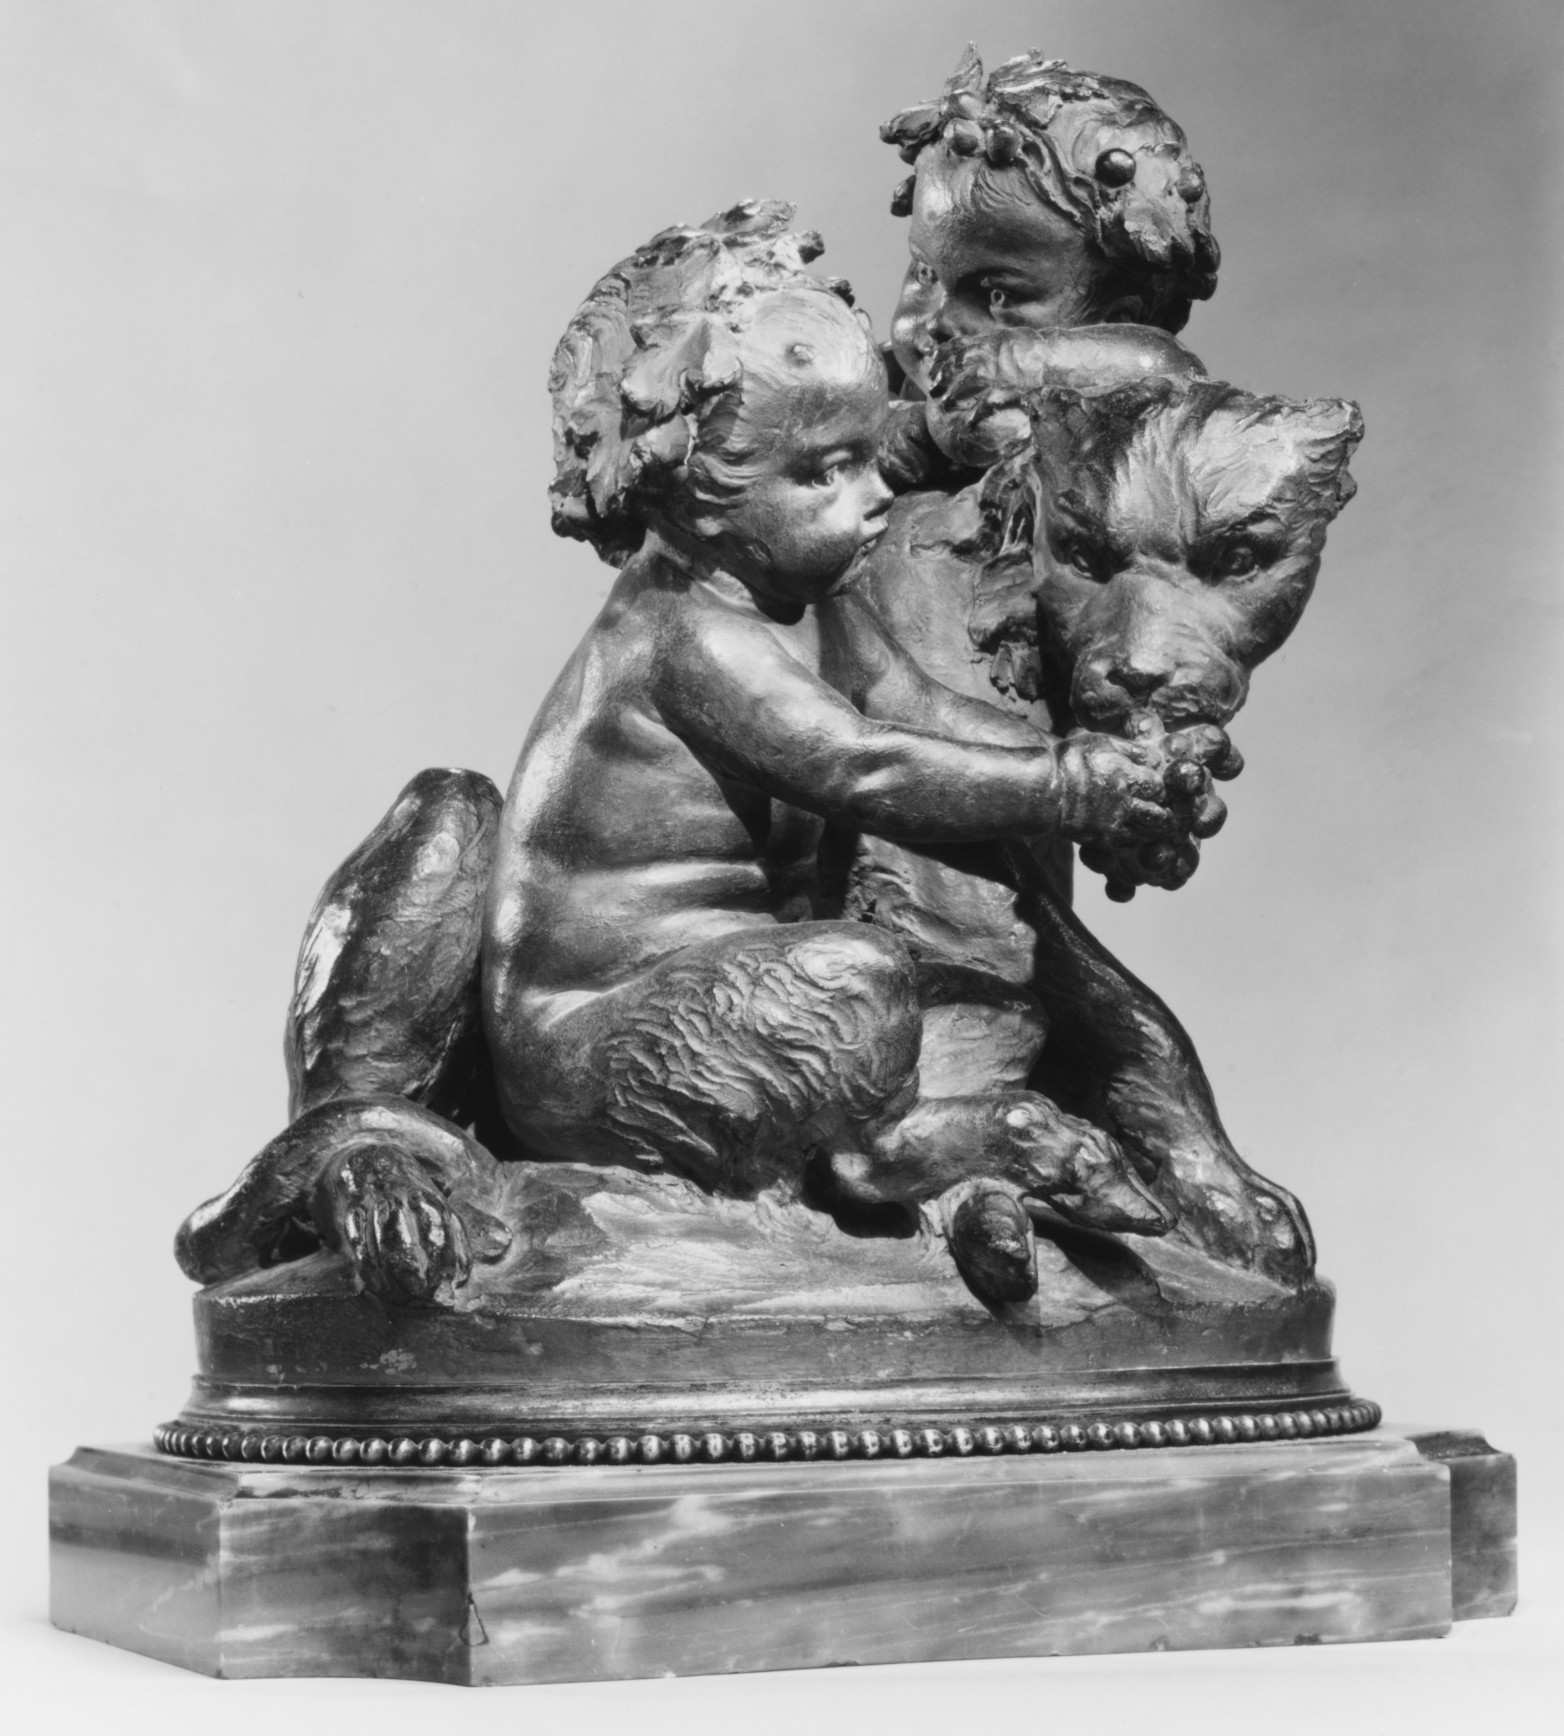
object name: statuette group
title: Infant and satyr child with a panther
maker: louis félix de la rue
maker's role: artist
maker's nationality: french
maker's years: 1731-1765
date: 1734-1766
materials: gilt bronze, marble, terracotta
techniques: lacquer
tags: animals,infants,satyrs